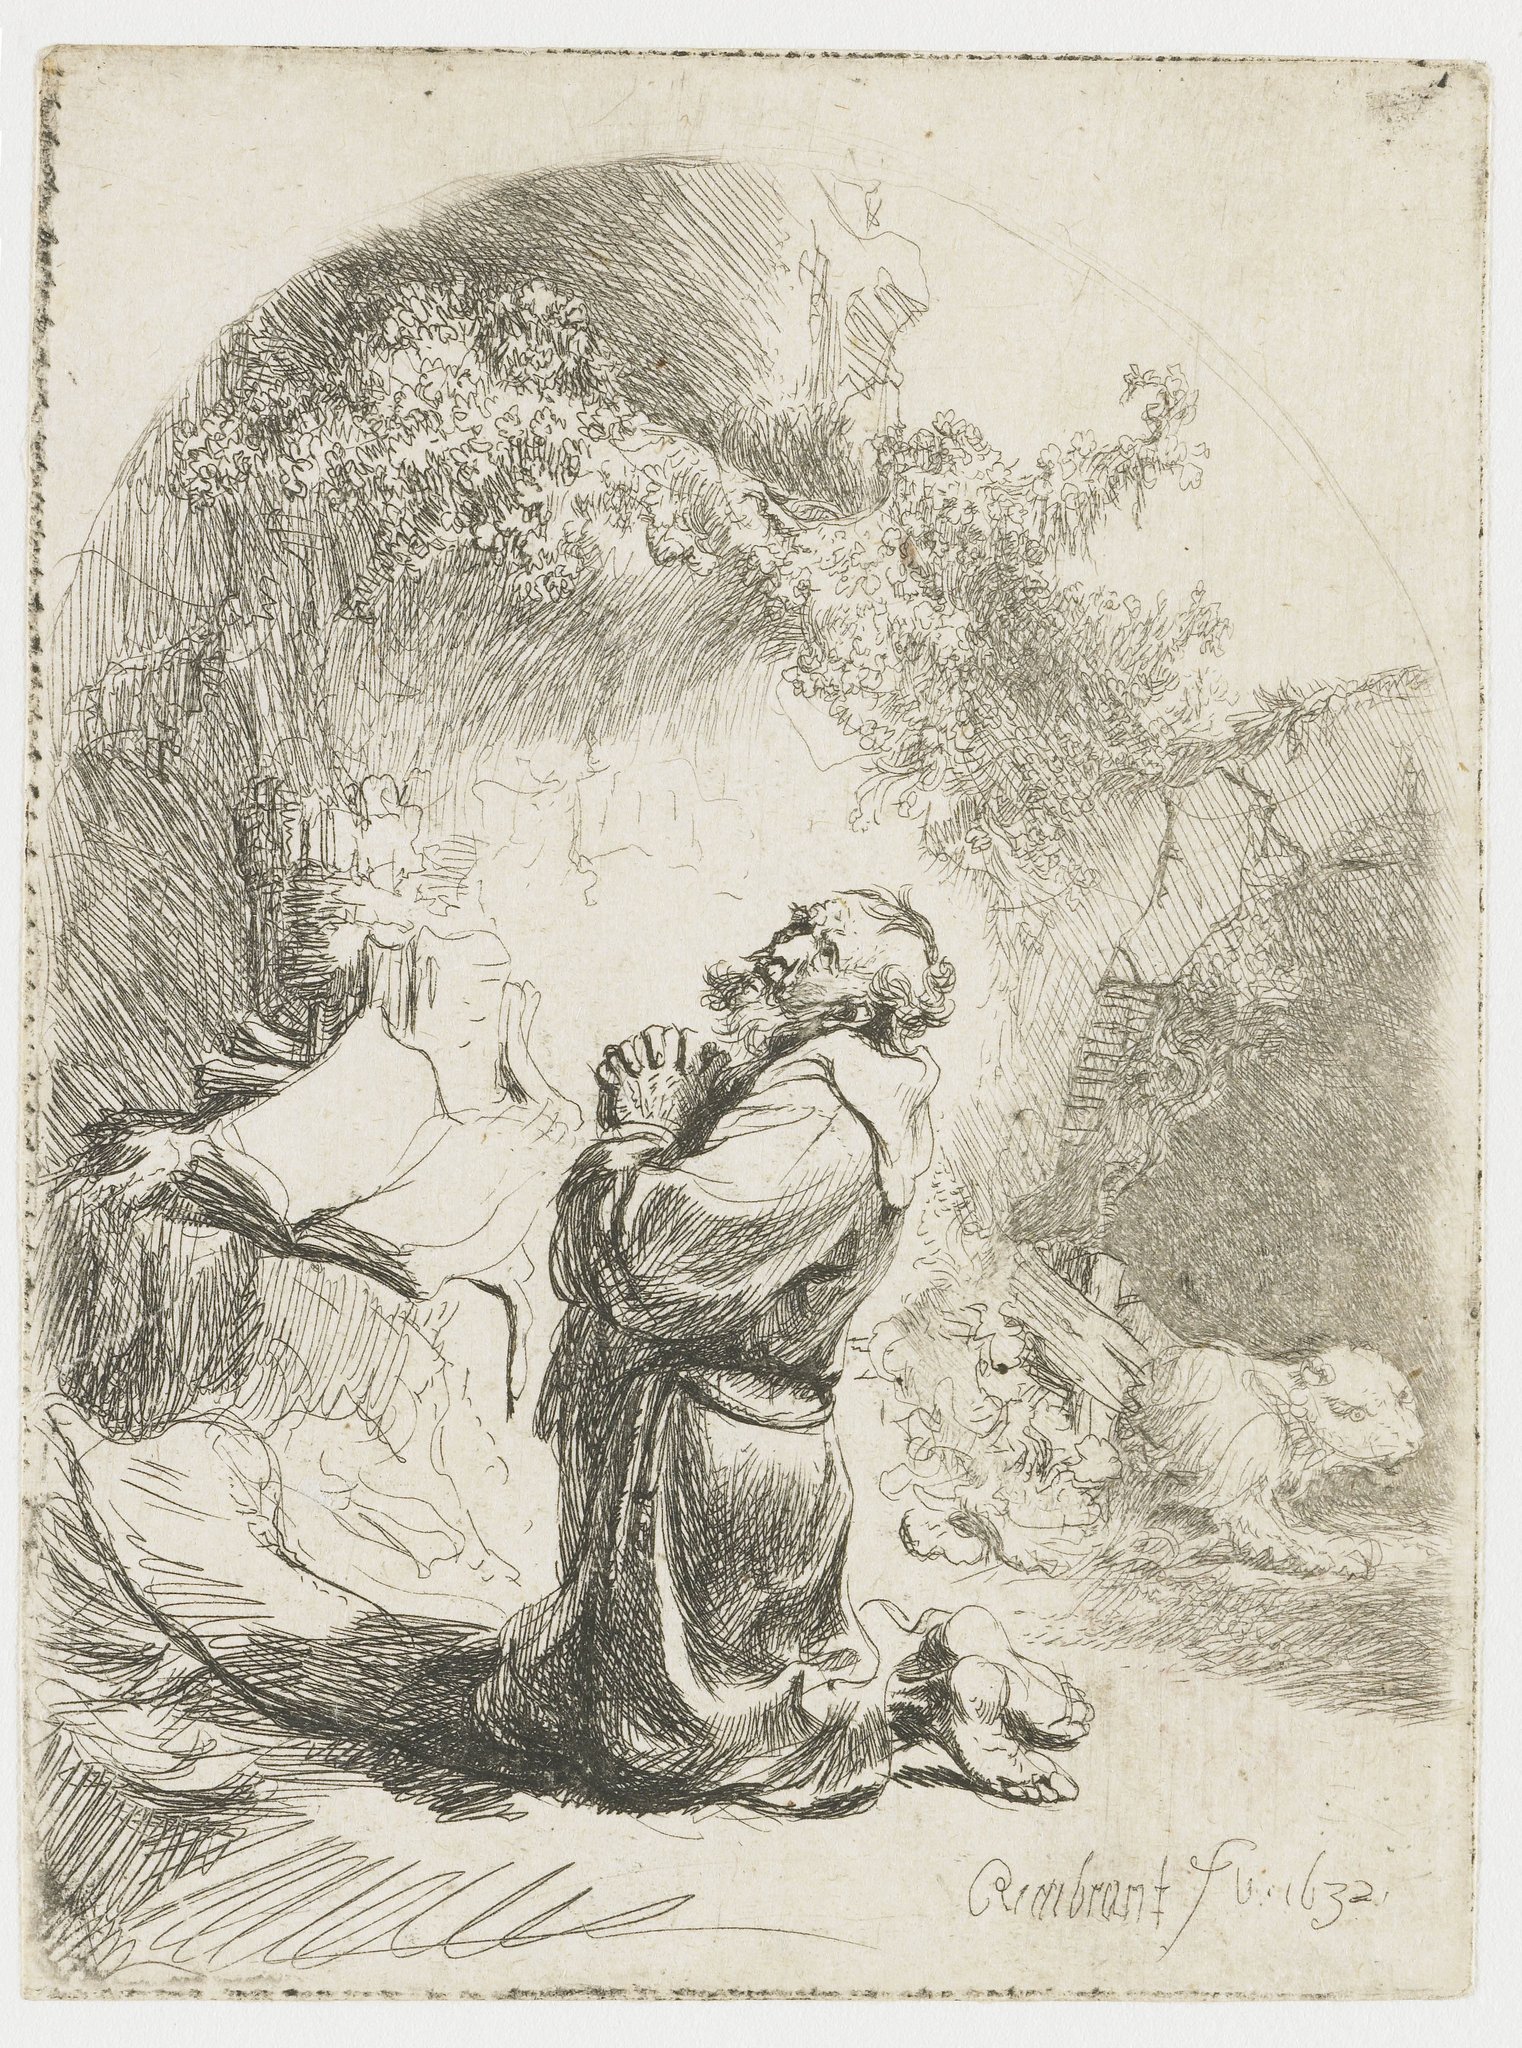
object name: print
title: St Jerome praying: arched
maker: rembrandt van rijn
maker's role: draughtsman, painter, print maker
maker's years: 1606-1669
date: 1632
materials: paper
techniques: etching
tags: the monk and hermit jerome (hieronymus); possible attributes: book, cardinal's hat, crucifix, hour-glass, lion, skull, stone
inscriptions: collector's mark: Lugt 240, signature and date: ‘Rembrandt f. 1632’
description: Jerome spent a part of his life in solitude in the desert. He is best known for having translated the Bible from Hebrew into Latin and thus was often represented in a study. However, from the late 16th century it became more common to portray him as a penitent hermit, a tradition Rembrandt followed here.